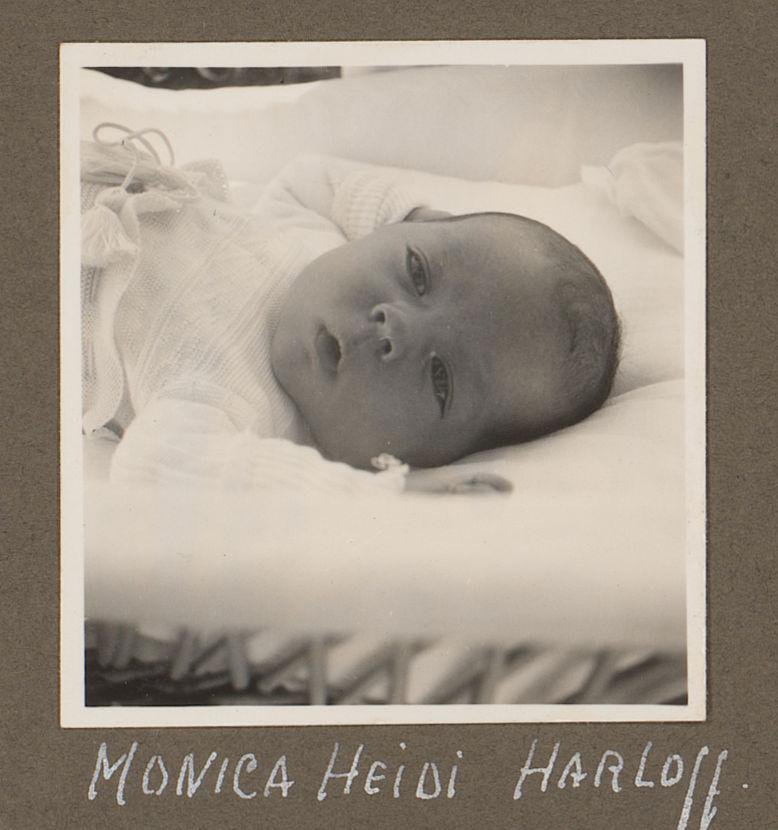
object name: album leaf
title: Portret van Monica Heidi Harloff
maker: Anonymous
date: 1934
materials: paper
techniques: gelatin silver print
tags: historical persons - bb - woman, female infant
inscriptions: inscription: ‘Monica Heidi Harloff.’